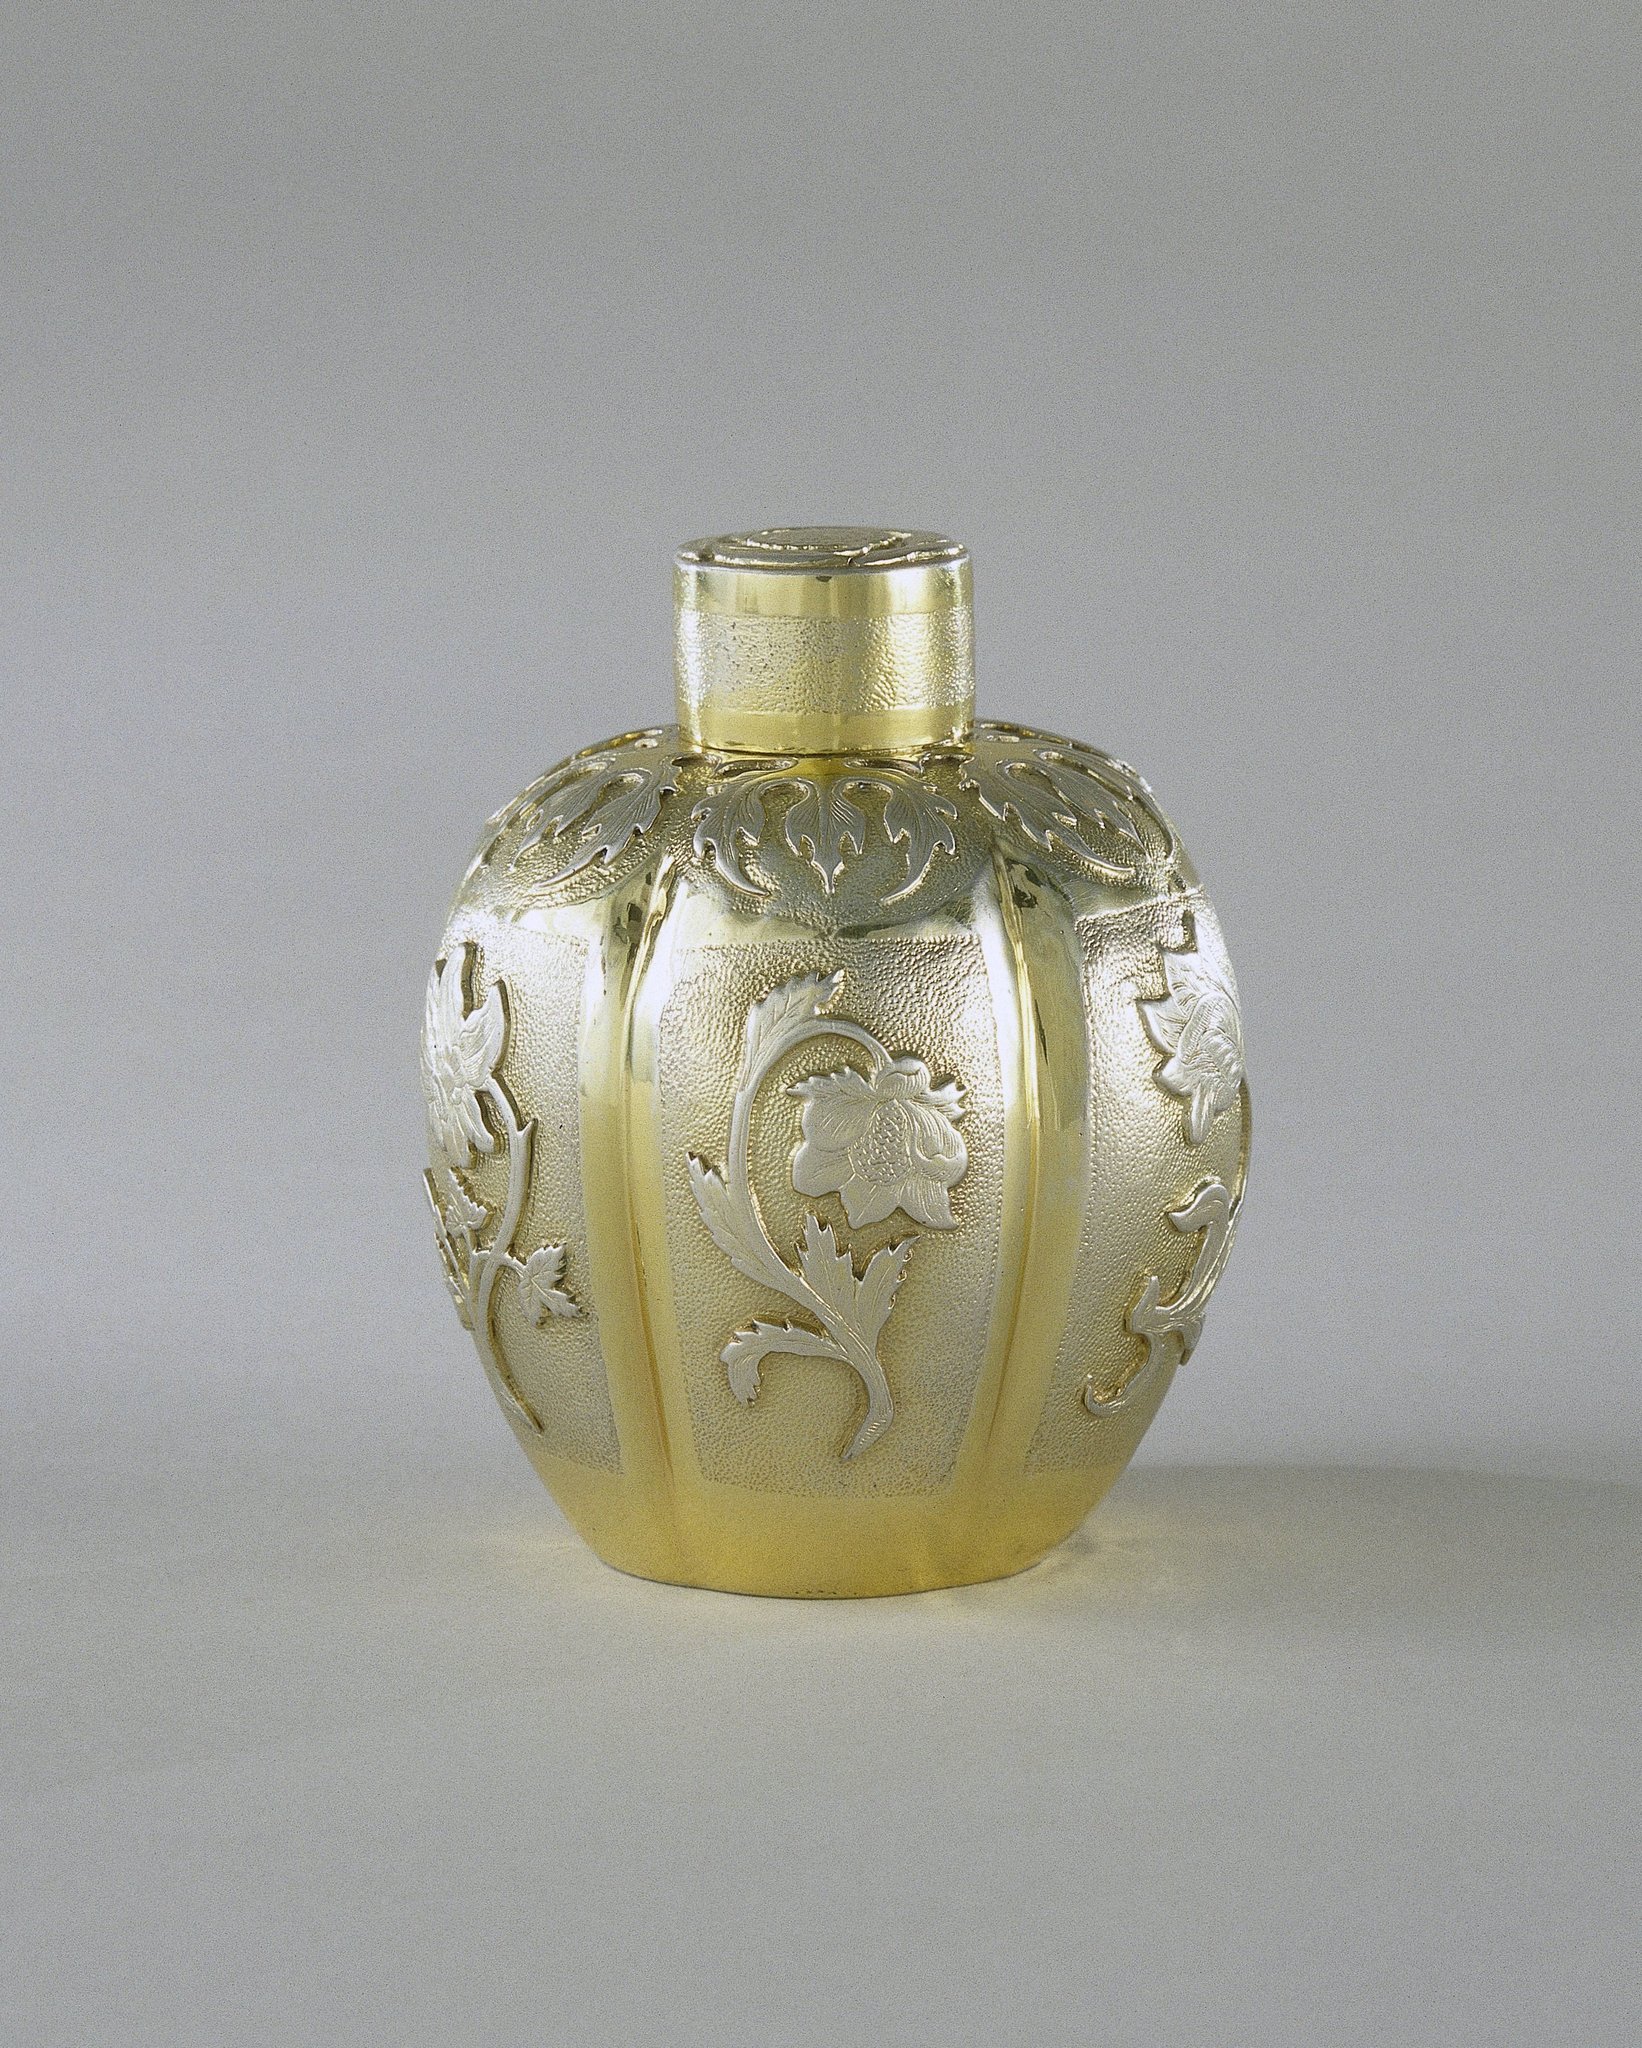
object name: tea caddy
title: Theebus met bloemen in cut card-techniek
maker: Anonymous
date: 1677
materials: silver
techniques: gilding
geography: amsterdam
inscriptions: date letter: ‘P’, maker's mark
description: Tea caddy. Silver, gilded. Amsterdam, 1677, unknown master. Given by Mrs J.E. van Schendel-Reesink, from the De Bruijn-van der Leeuw estate, Amsterdam, 1989.